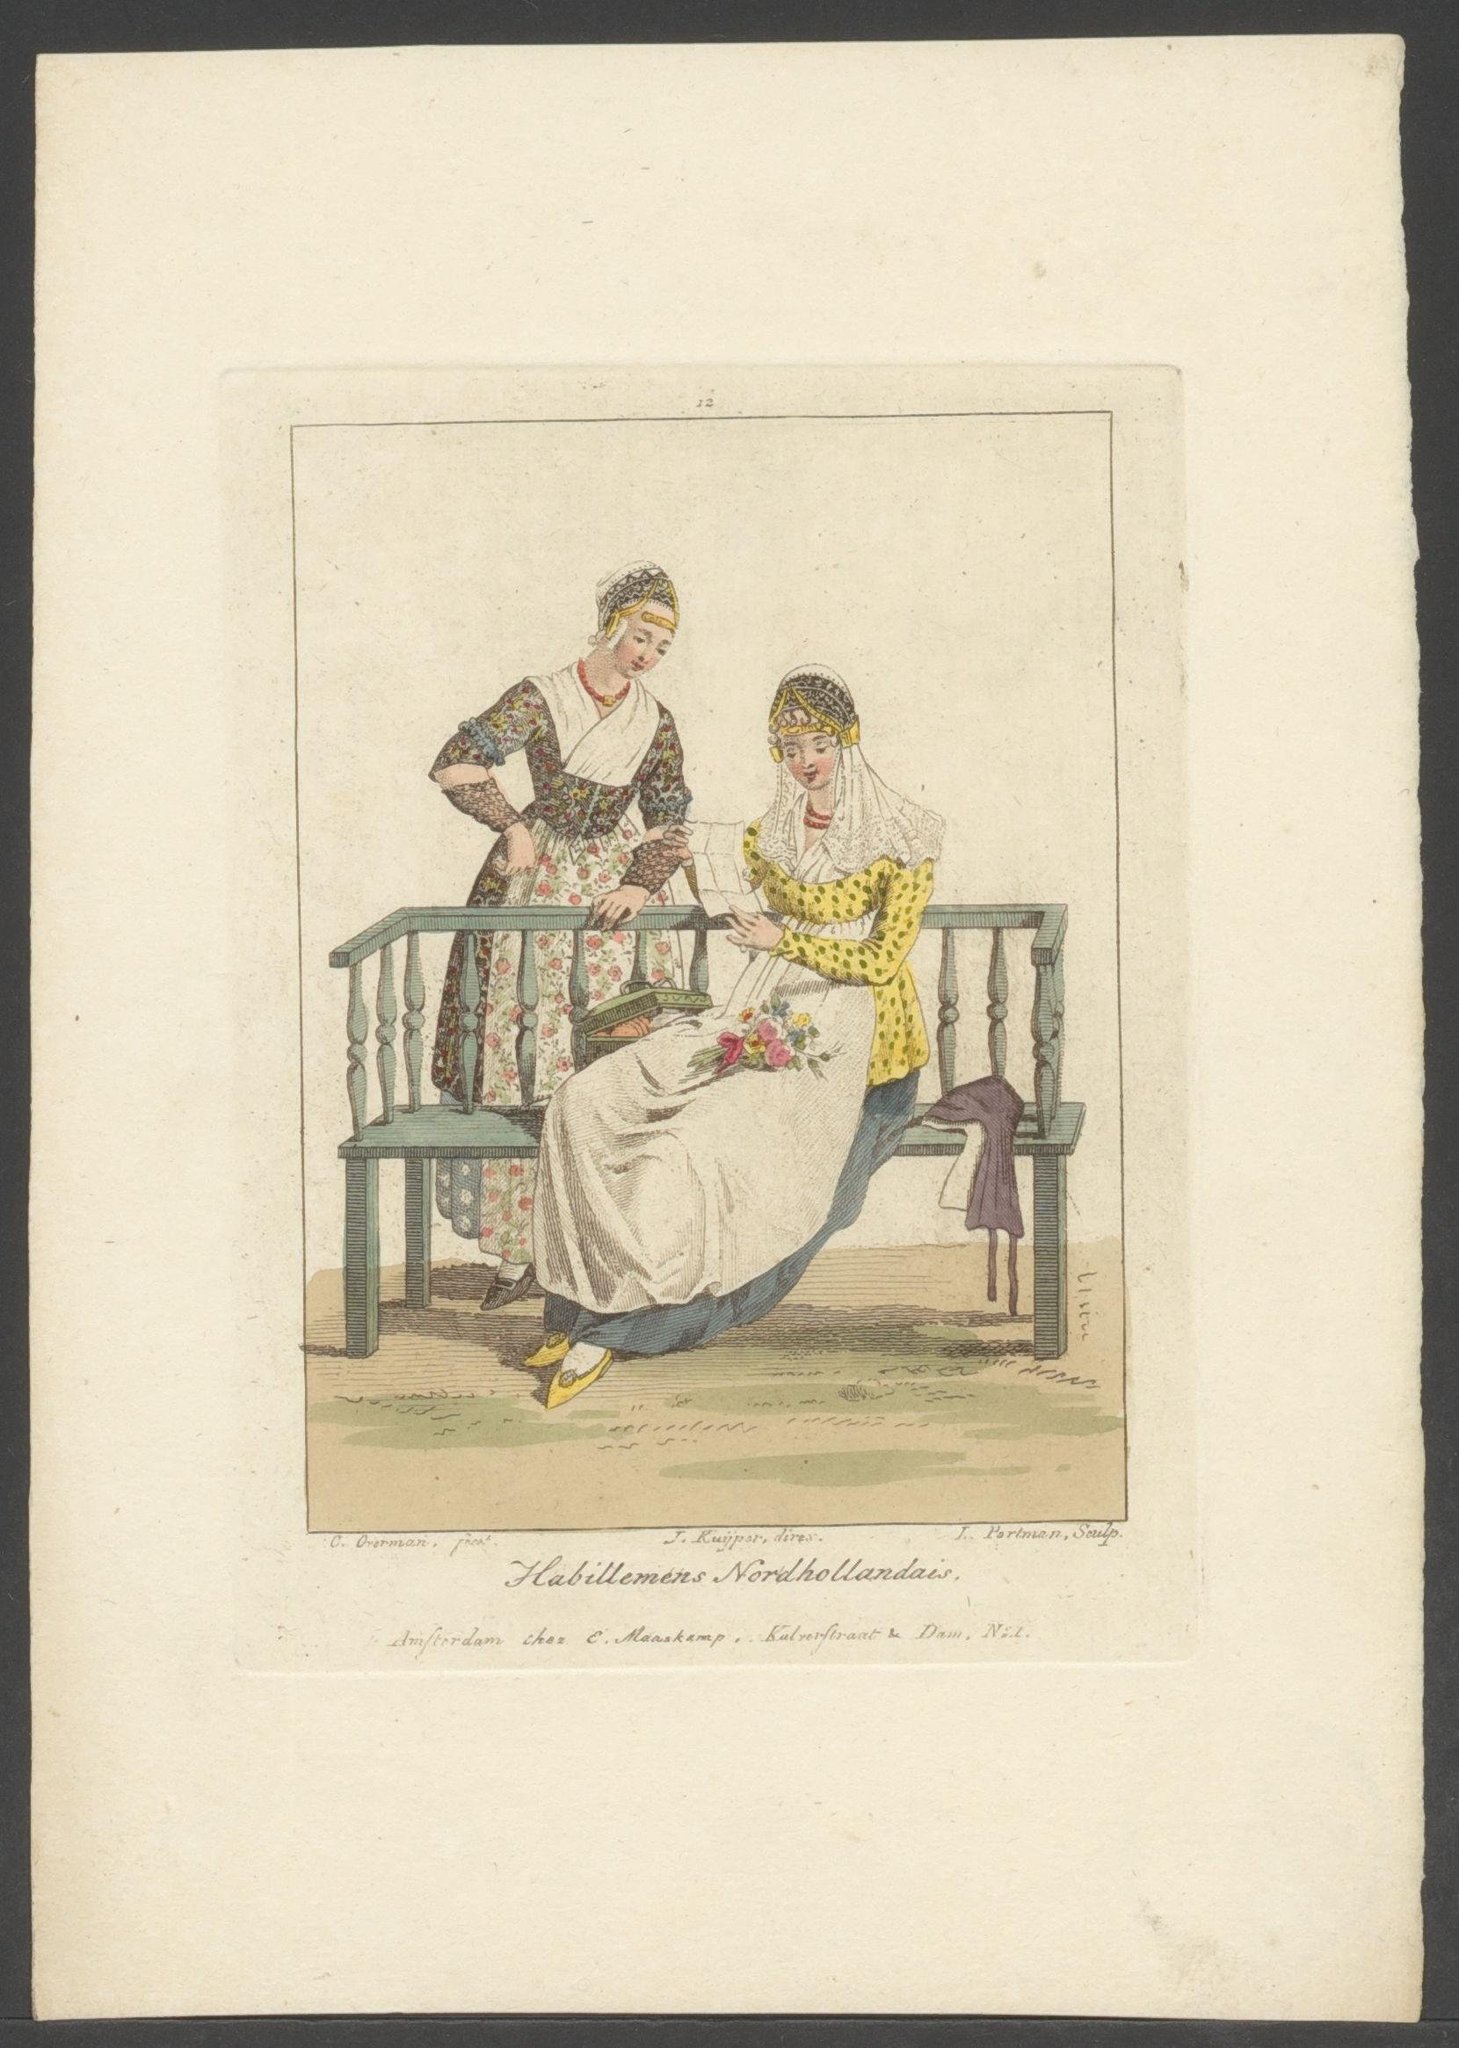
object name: costume print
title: Des Filles de Nord-Hollande se promenant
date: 1813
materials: paper, watercolor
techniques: etching, hand coloring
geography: netherlands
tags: clothes, costume (+ women's clothes), folk costume, regional costume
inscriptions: collector's mark, collector's mark: Lugt 1641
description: Twee jonge dames van Noord-Holland. Een vrouw staande bij de andere die zittend op een bank een brief leest. Bij de prent zit ook een blad met de Franse titel. Onderdeel van de verkleinde kopieën uit 1812 naar de platen van Nederlandse klederdrachten uit de jaren 1803-1807. Onderwerpsrubrieken binnen de Atlas Zeden en Gewoonten: De Kleeding, Volkskleederdracht.